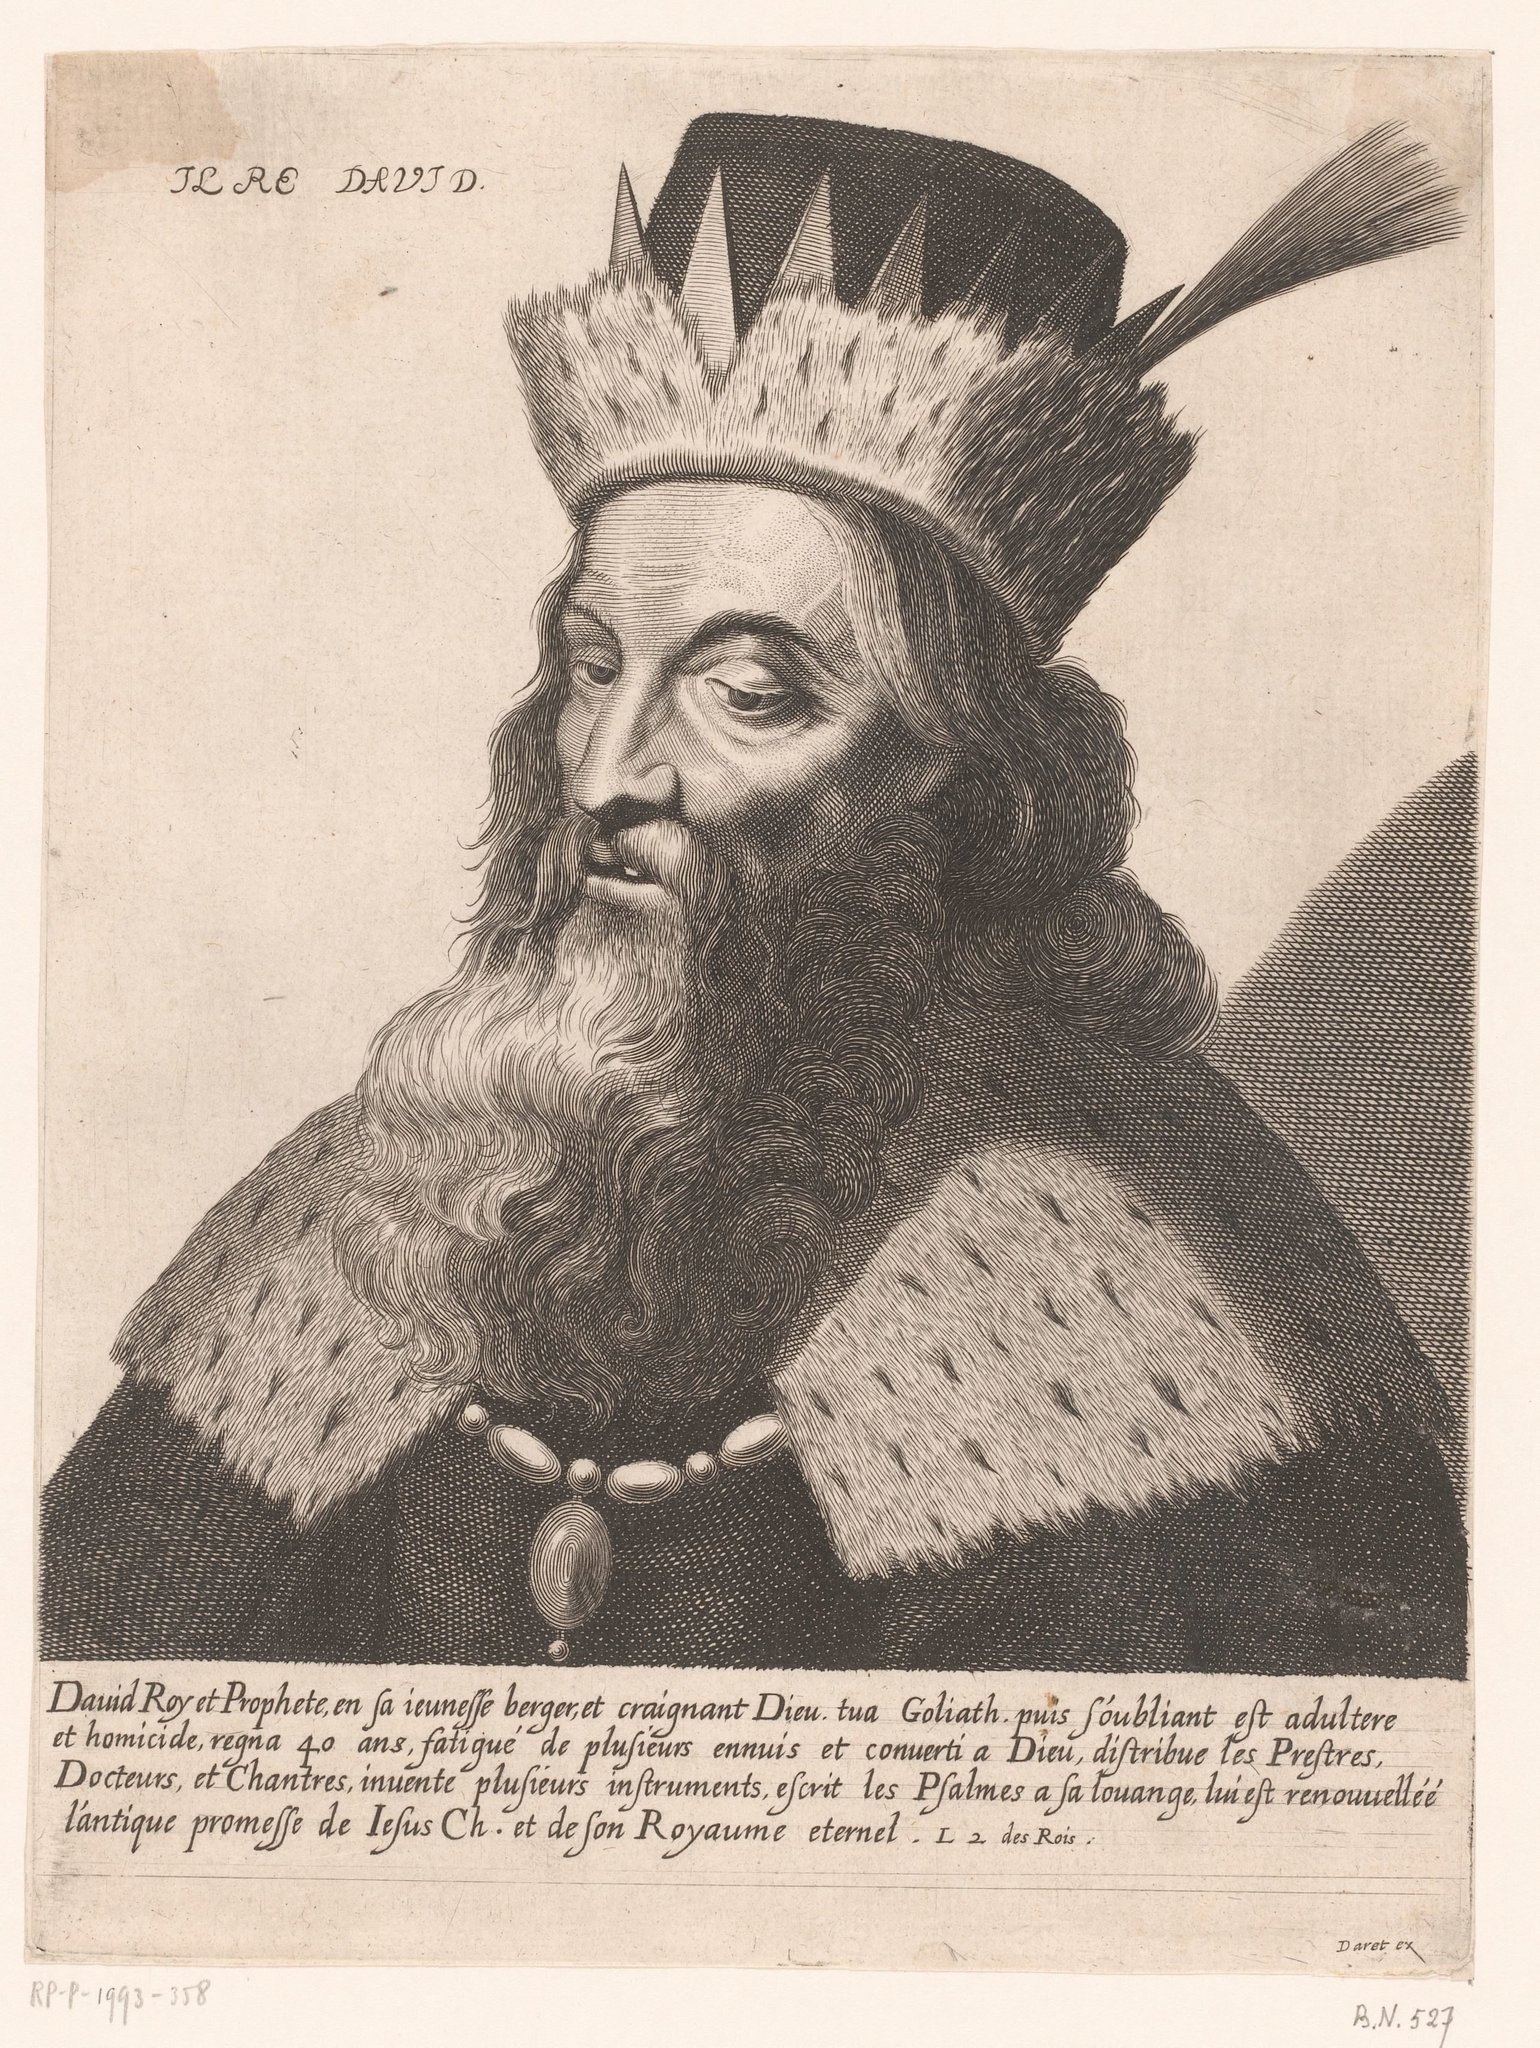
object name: print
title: Portretten van koningen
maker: pierre daret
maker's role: print maker, publisher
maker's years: 1604-1678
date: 1624-1678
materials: paper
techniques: engraving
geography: france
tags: david (not in biblical context); possible attributes: crown, harp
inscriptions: inscription: ‘l.b., naast de muts: Il Re David / onder de voorstelling: David Roy et Prophete....Royaume eternel. L.2 des Rois.’, signature and date: ‘r.o.: Daret exc.’, collector's mark: Lugt 2228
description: David is gekleed in hermelijnen mantel en draagt een muts met hermelijnen rand en een veer op zijn hoofd. Om zijn hals een ambtsketen.